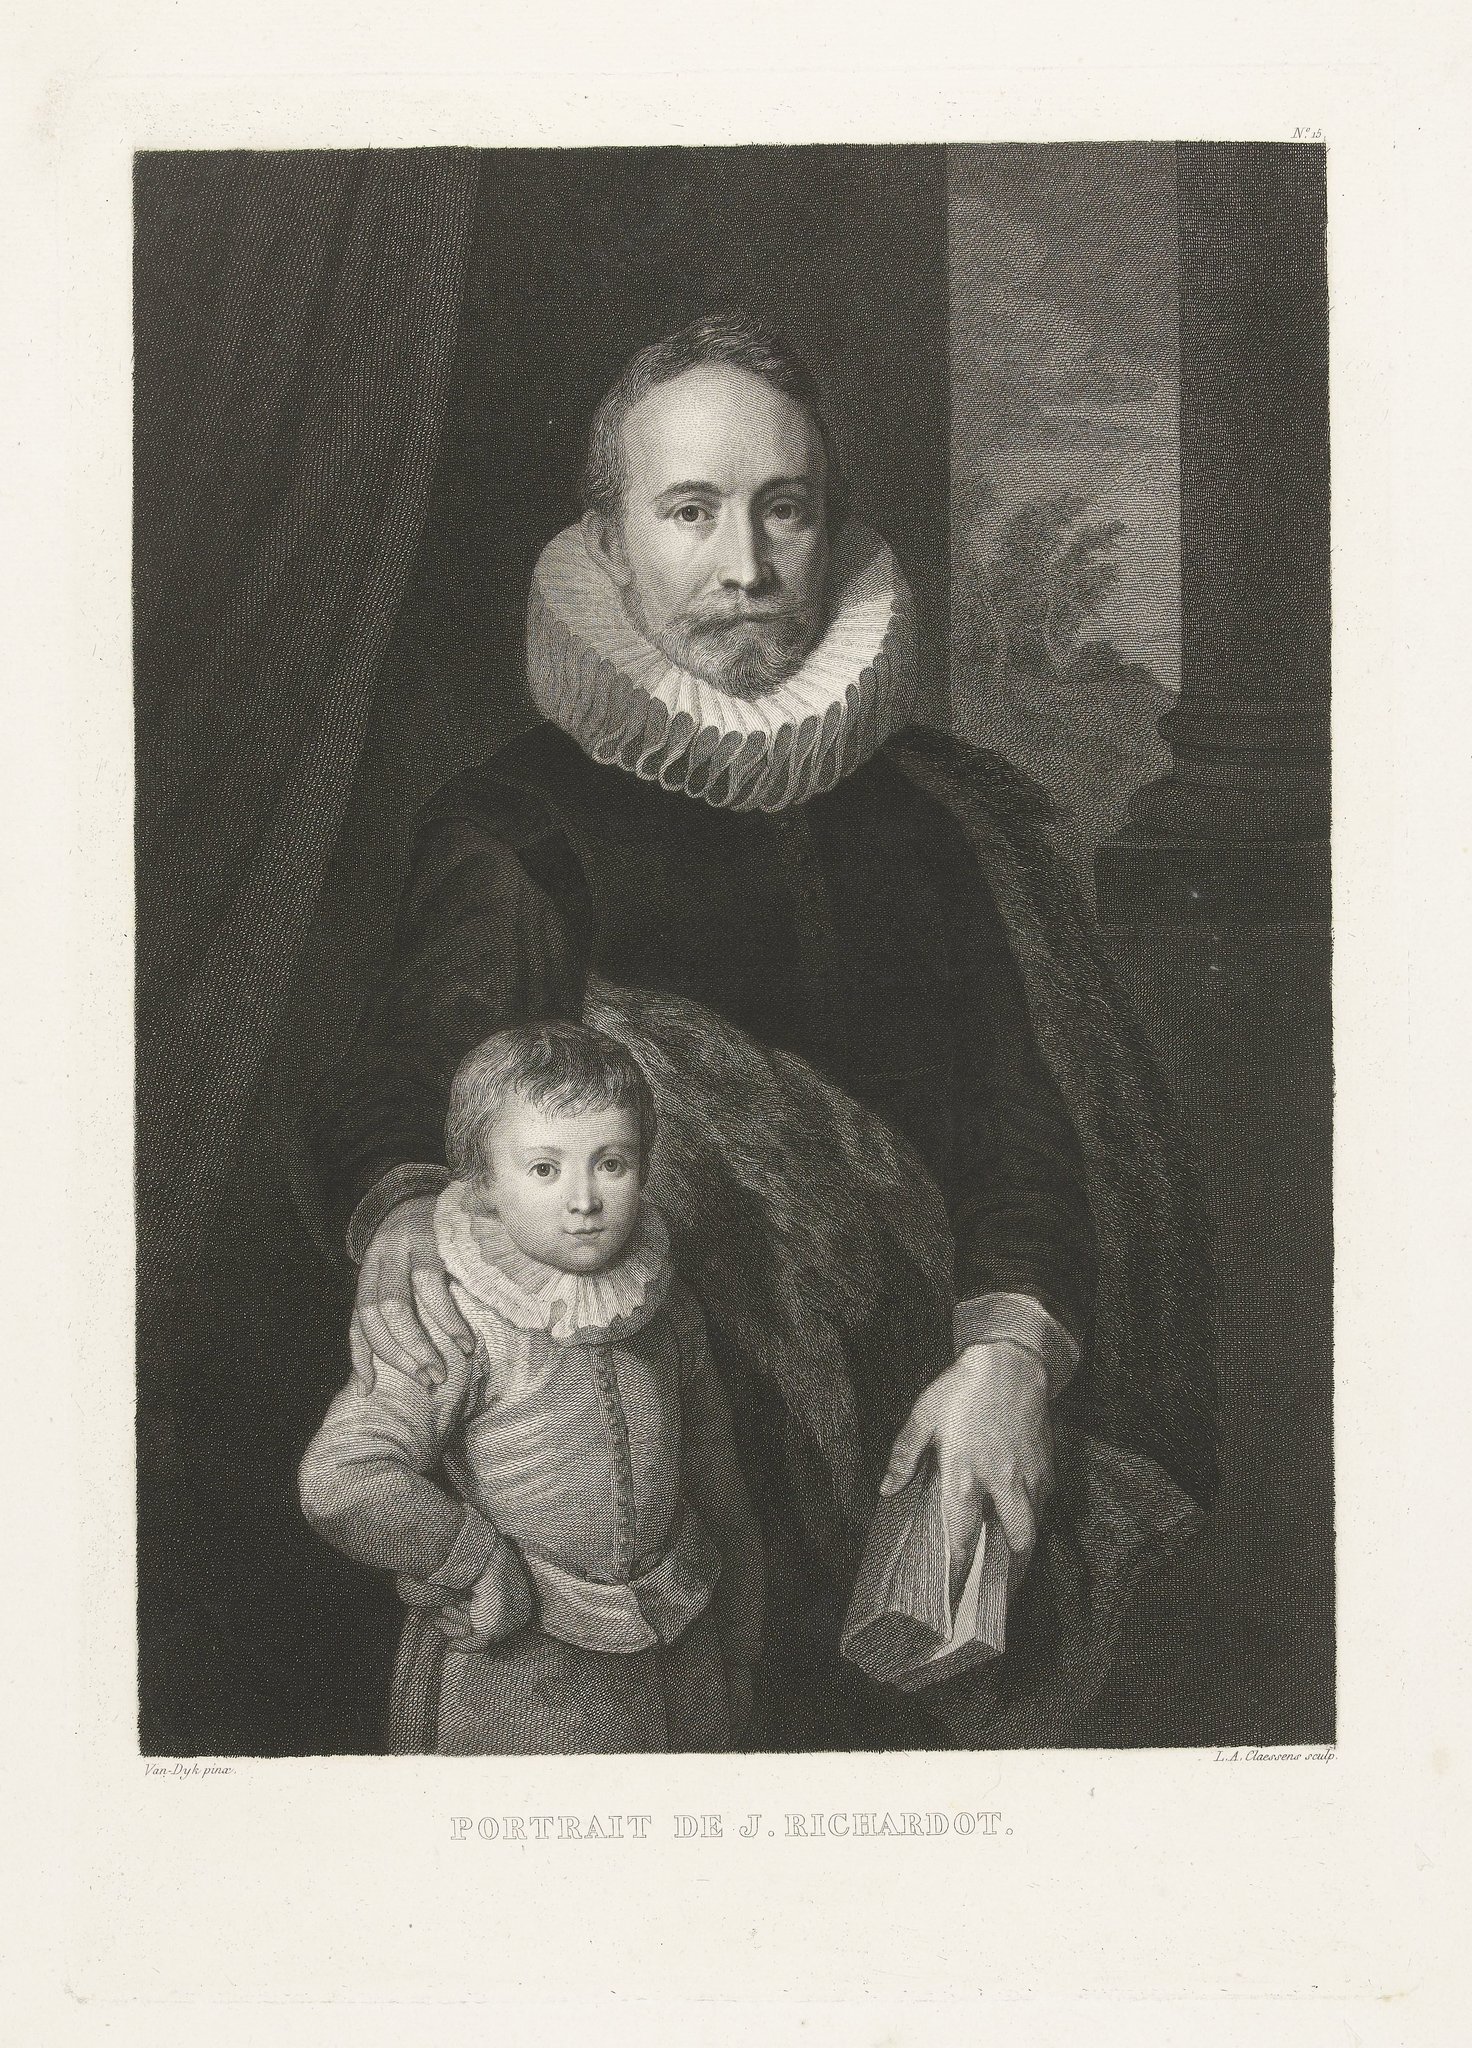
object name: print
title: Portret van een man en zijn zoon, voorheen bekend als Jean Richardot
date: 1829-1834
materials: paper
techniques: engraving, etching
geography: paris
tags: jean richardot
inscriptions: collector's mark: Lugt 2228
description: De man houdt een boek in zijn hand. Zijn andere hand rust op de schouder van zijn zoon. Beiden staan voor een gordijn in een donkere ruimte met rechts een pilaar.